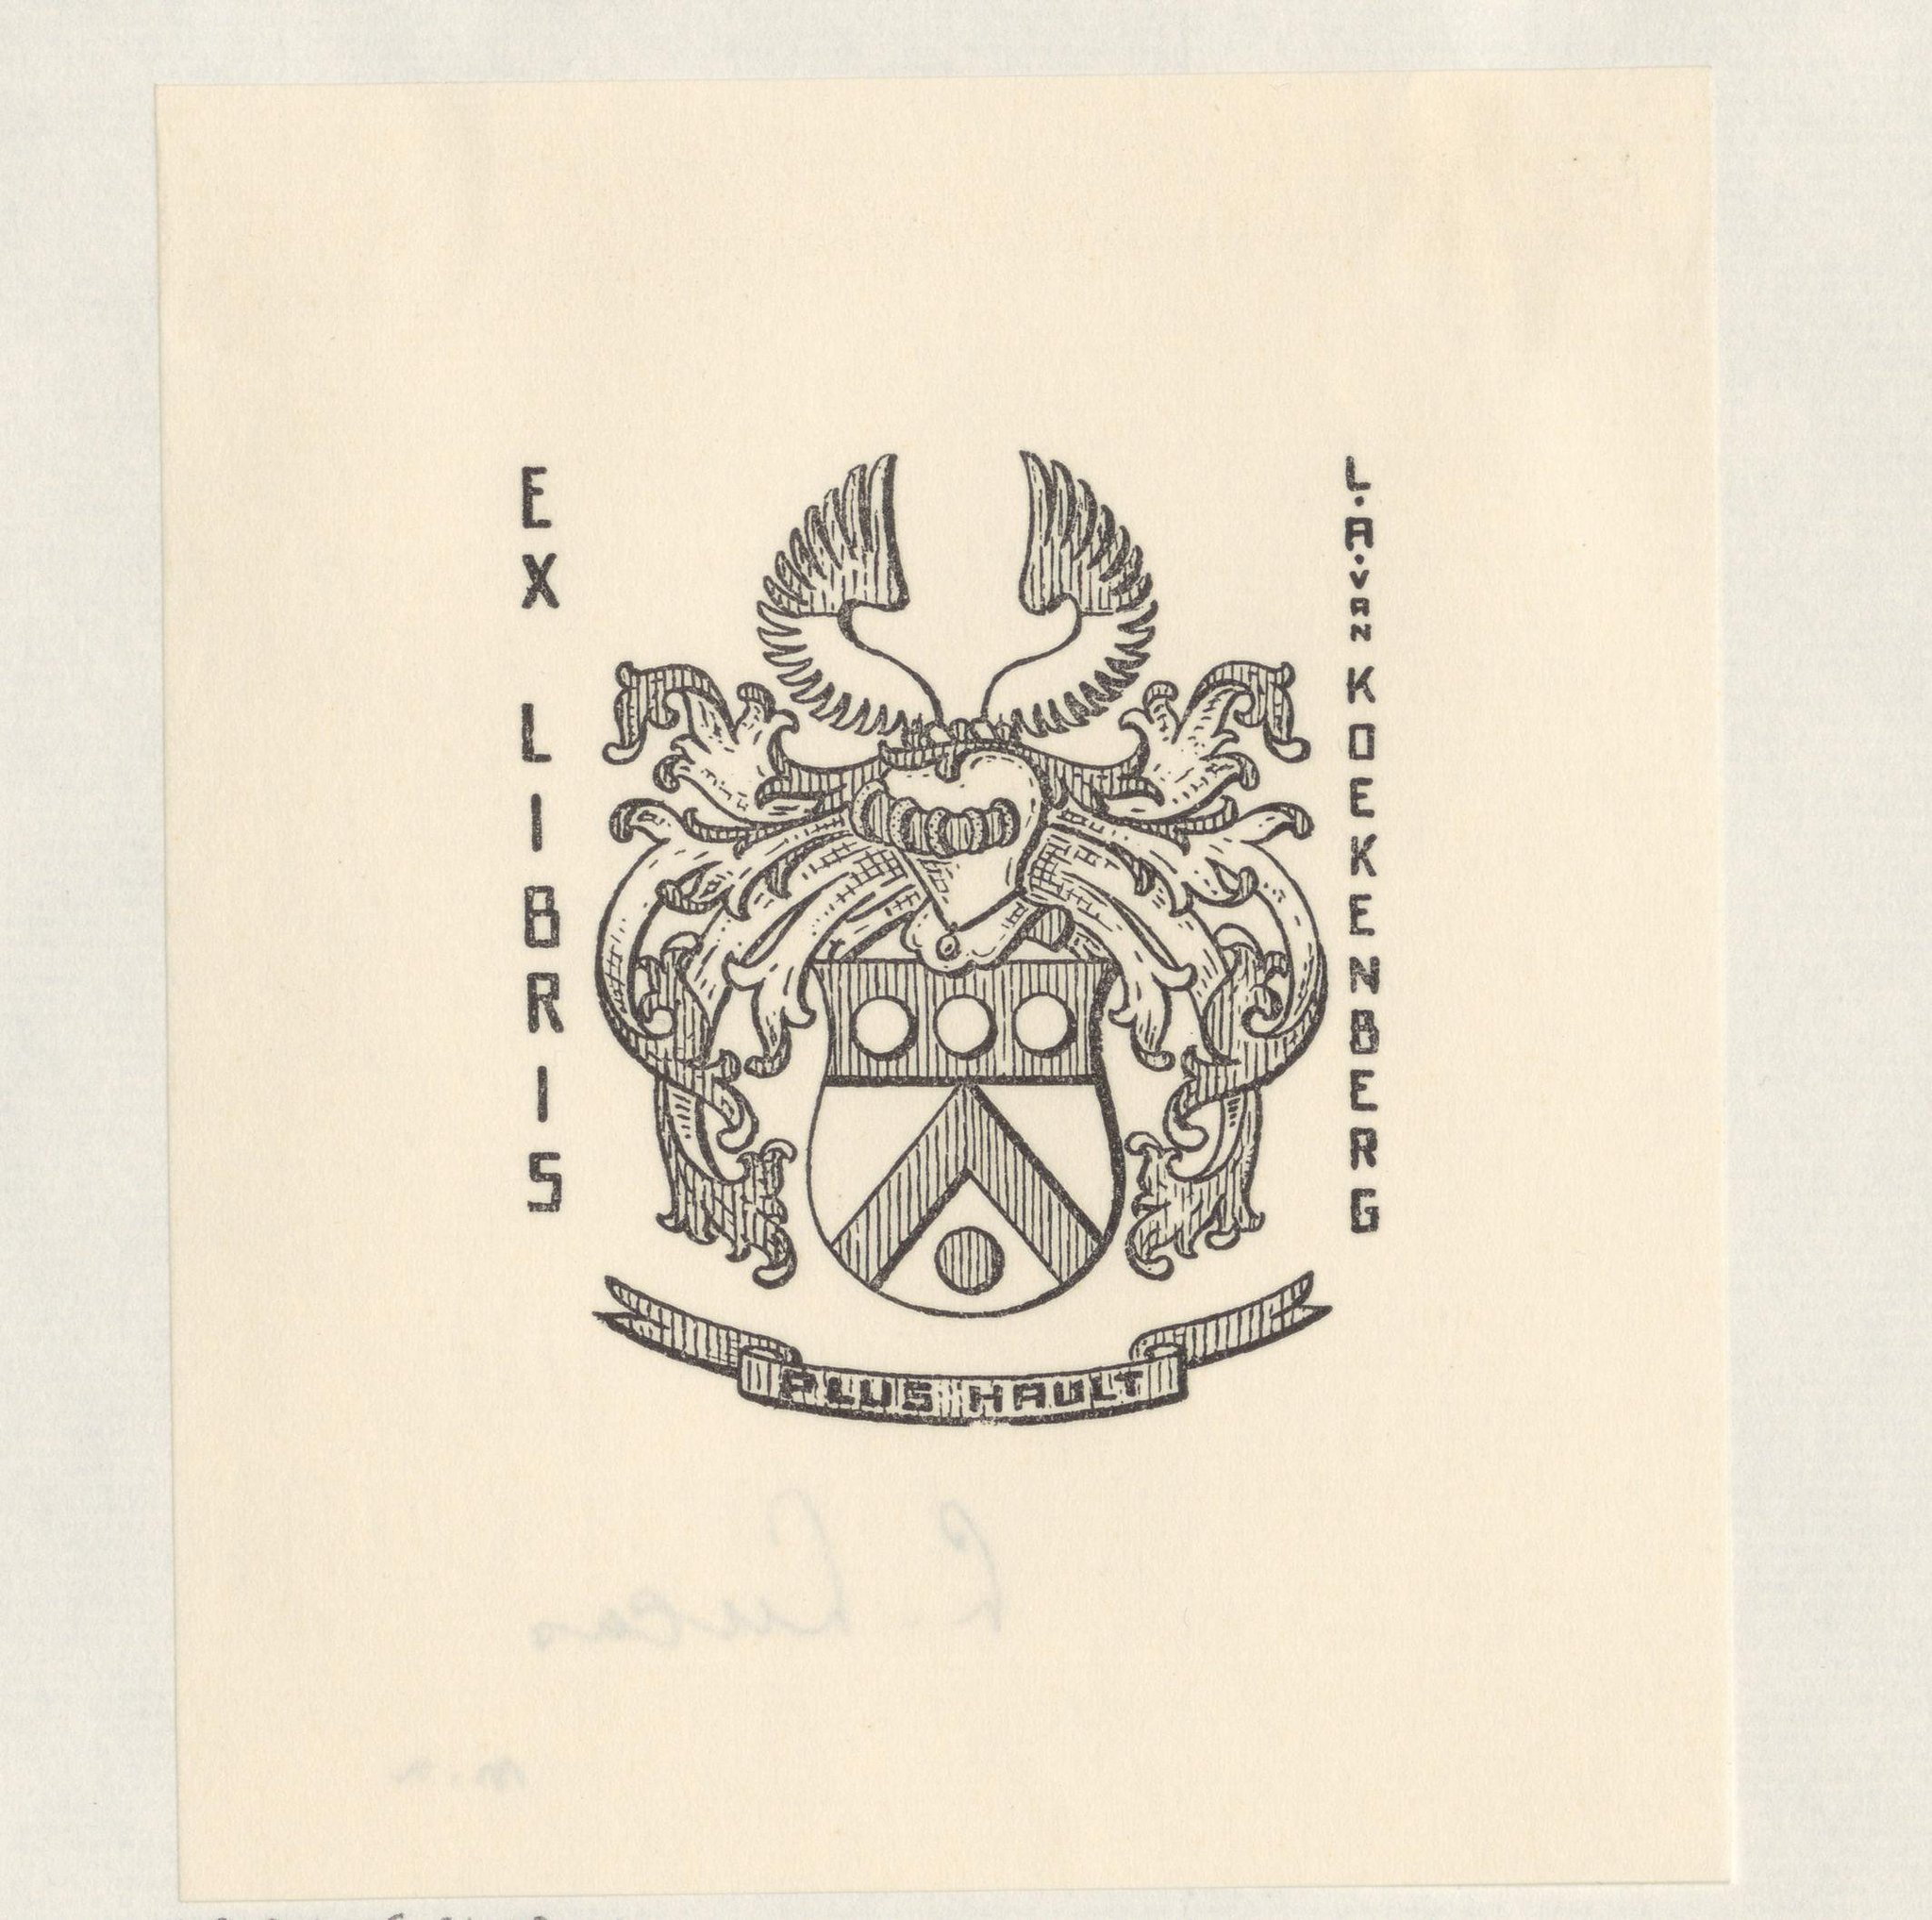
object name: bookplate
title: Plus hault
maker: l. lucas (twintigste-eeuws)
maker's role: print maker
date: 1900-1999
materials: paper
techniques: printing block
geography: netherlands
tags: the hague, armorial bearing, heraldry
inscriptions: inscription: ‘L. Lucas’